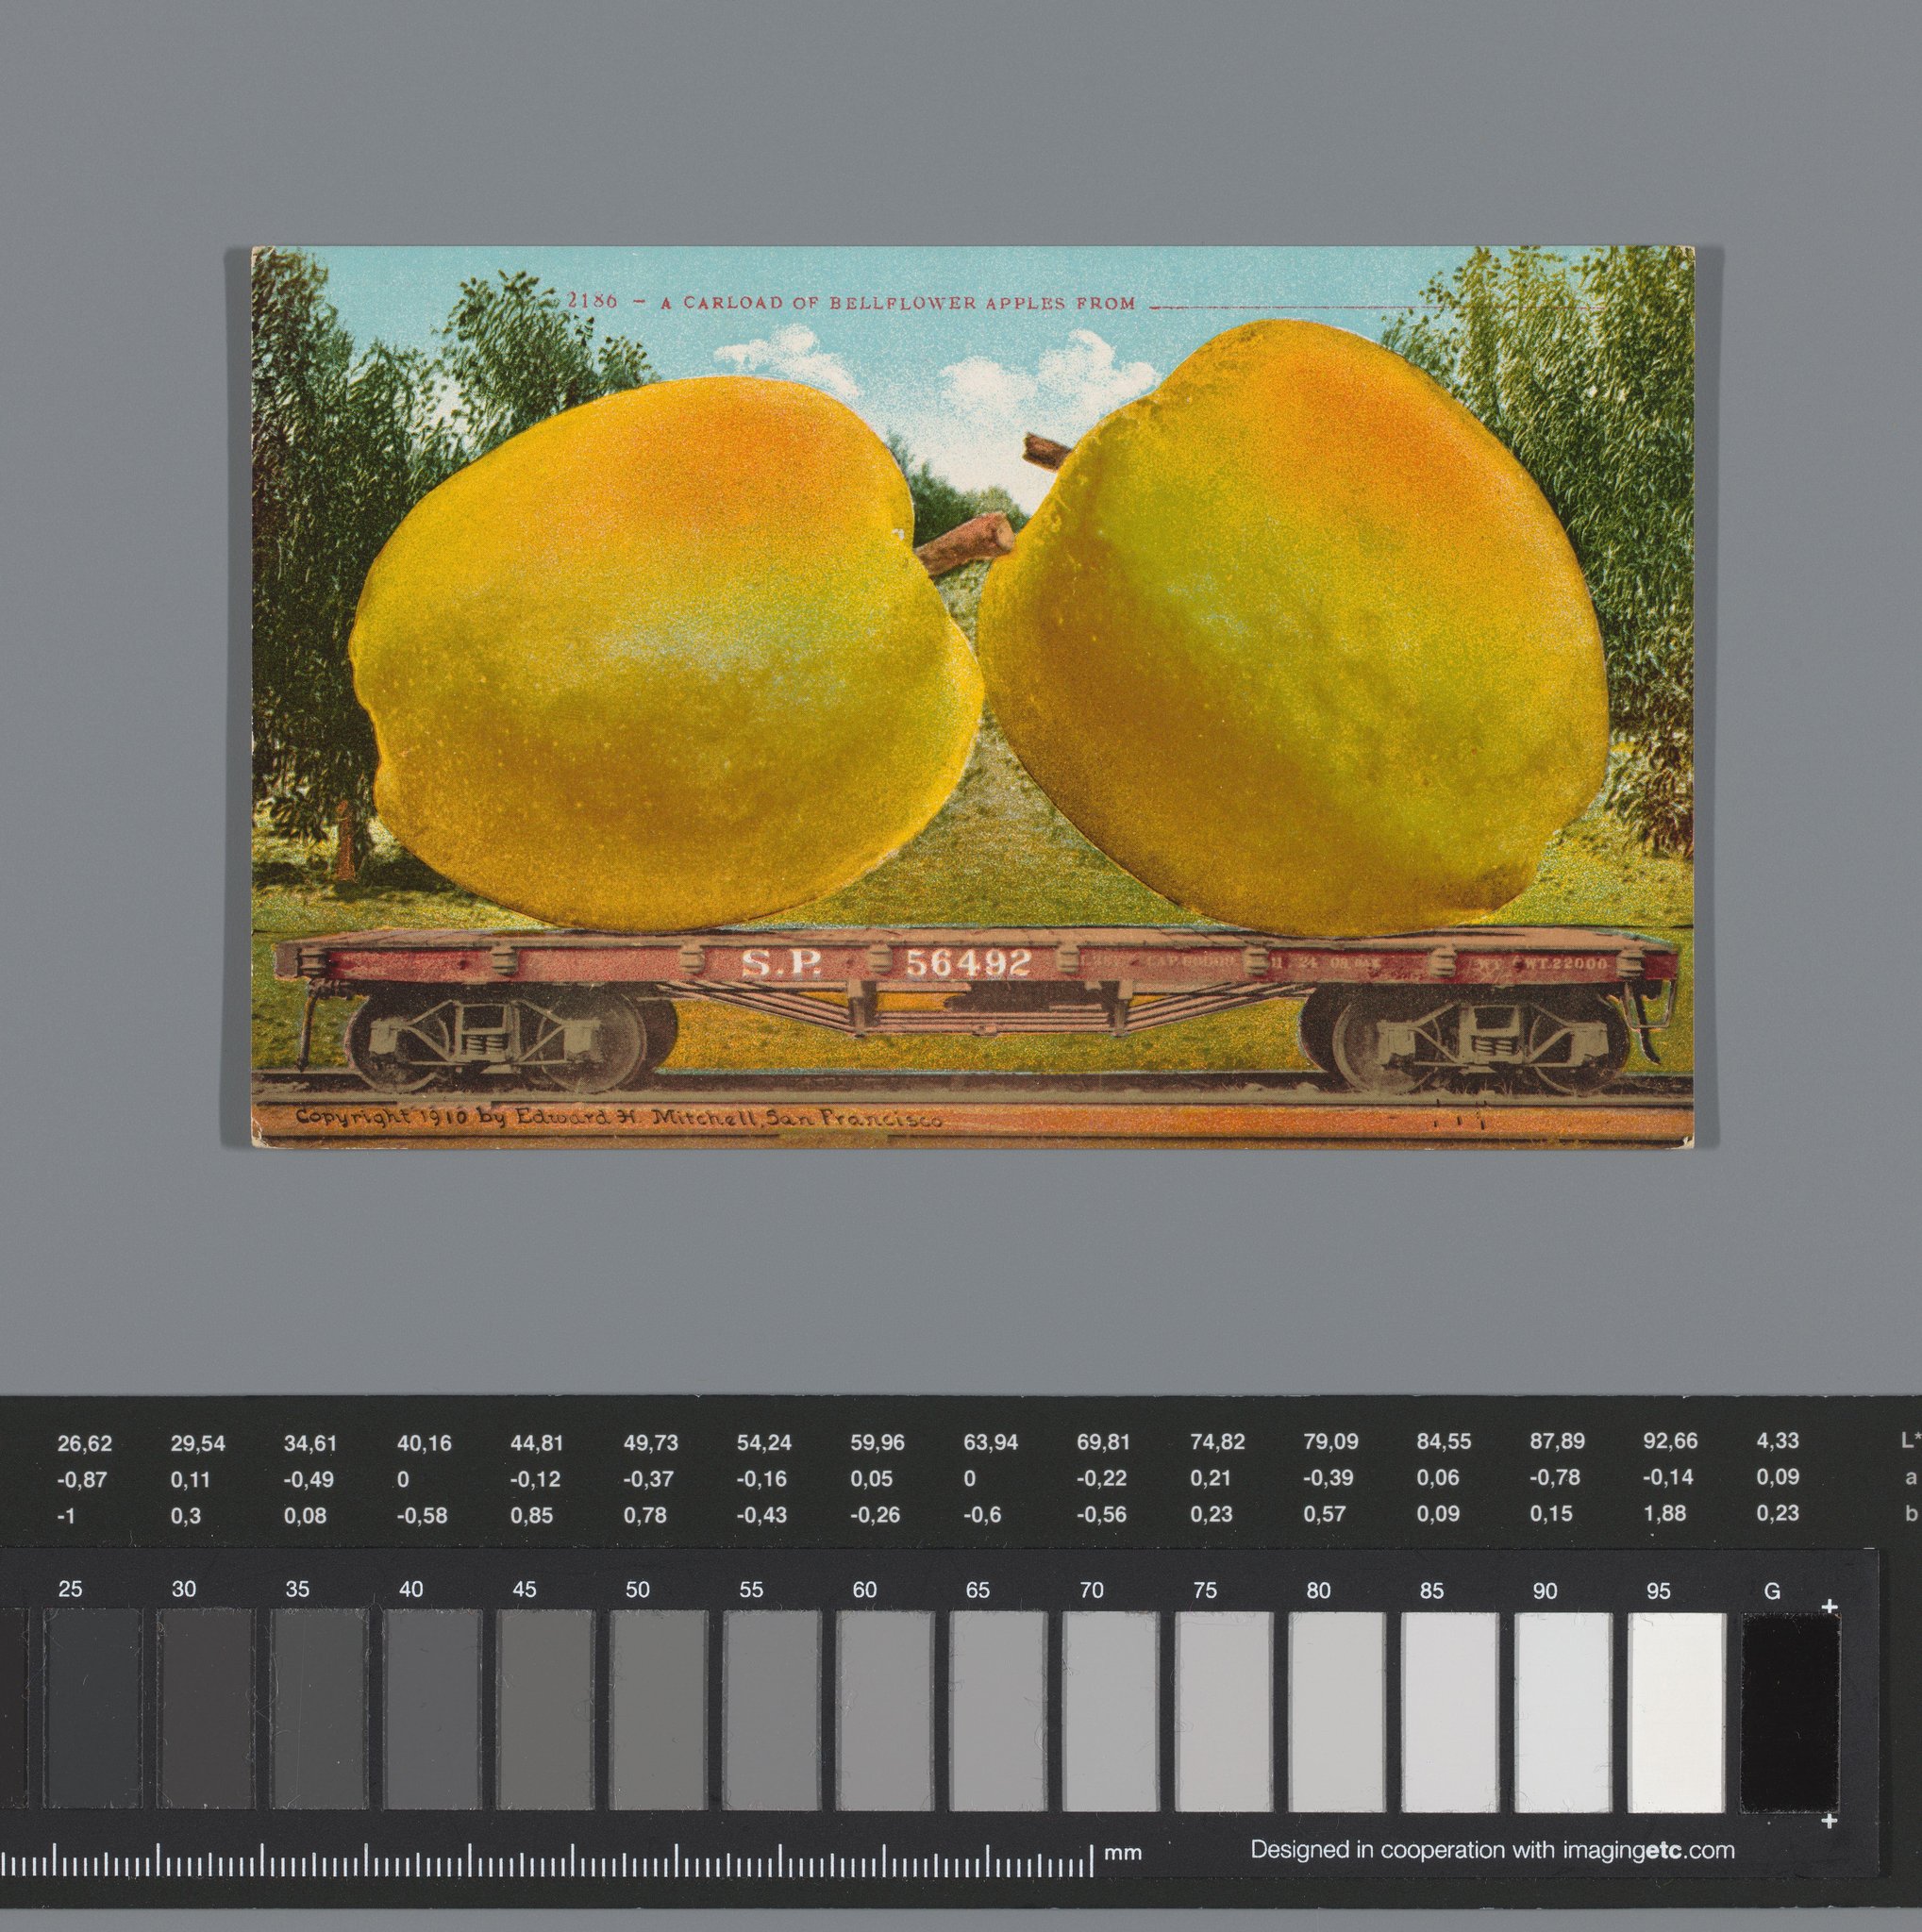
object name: ansichtkaart, prentbriefkaart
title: Treinwagon met twee reusachtige appels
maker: edward henri mitchell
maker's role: publisher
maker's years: 1867-1932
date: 1910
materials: cardboard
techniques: lithograph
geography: san francisco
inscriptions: inscription: ‘MADE IN AMERICA BY EDW. H. MITCHELL AT SAN FRANCISCO CALIFORNIA’, inscription: ‘2186 – A CARLOAD OF BELLFLOWER APPLES FROM / S. P. 56492 / Copyright 1910 by Edward H. Mitchell, San Francisco’